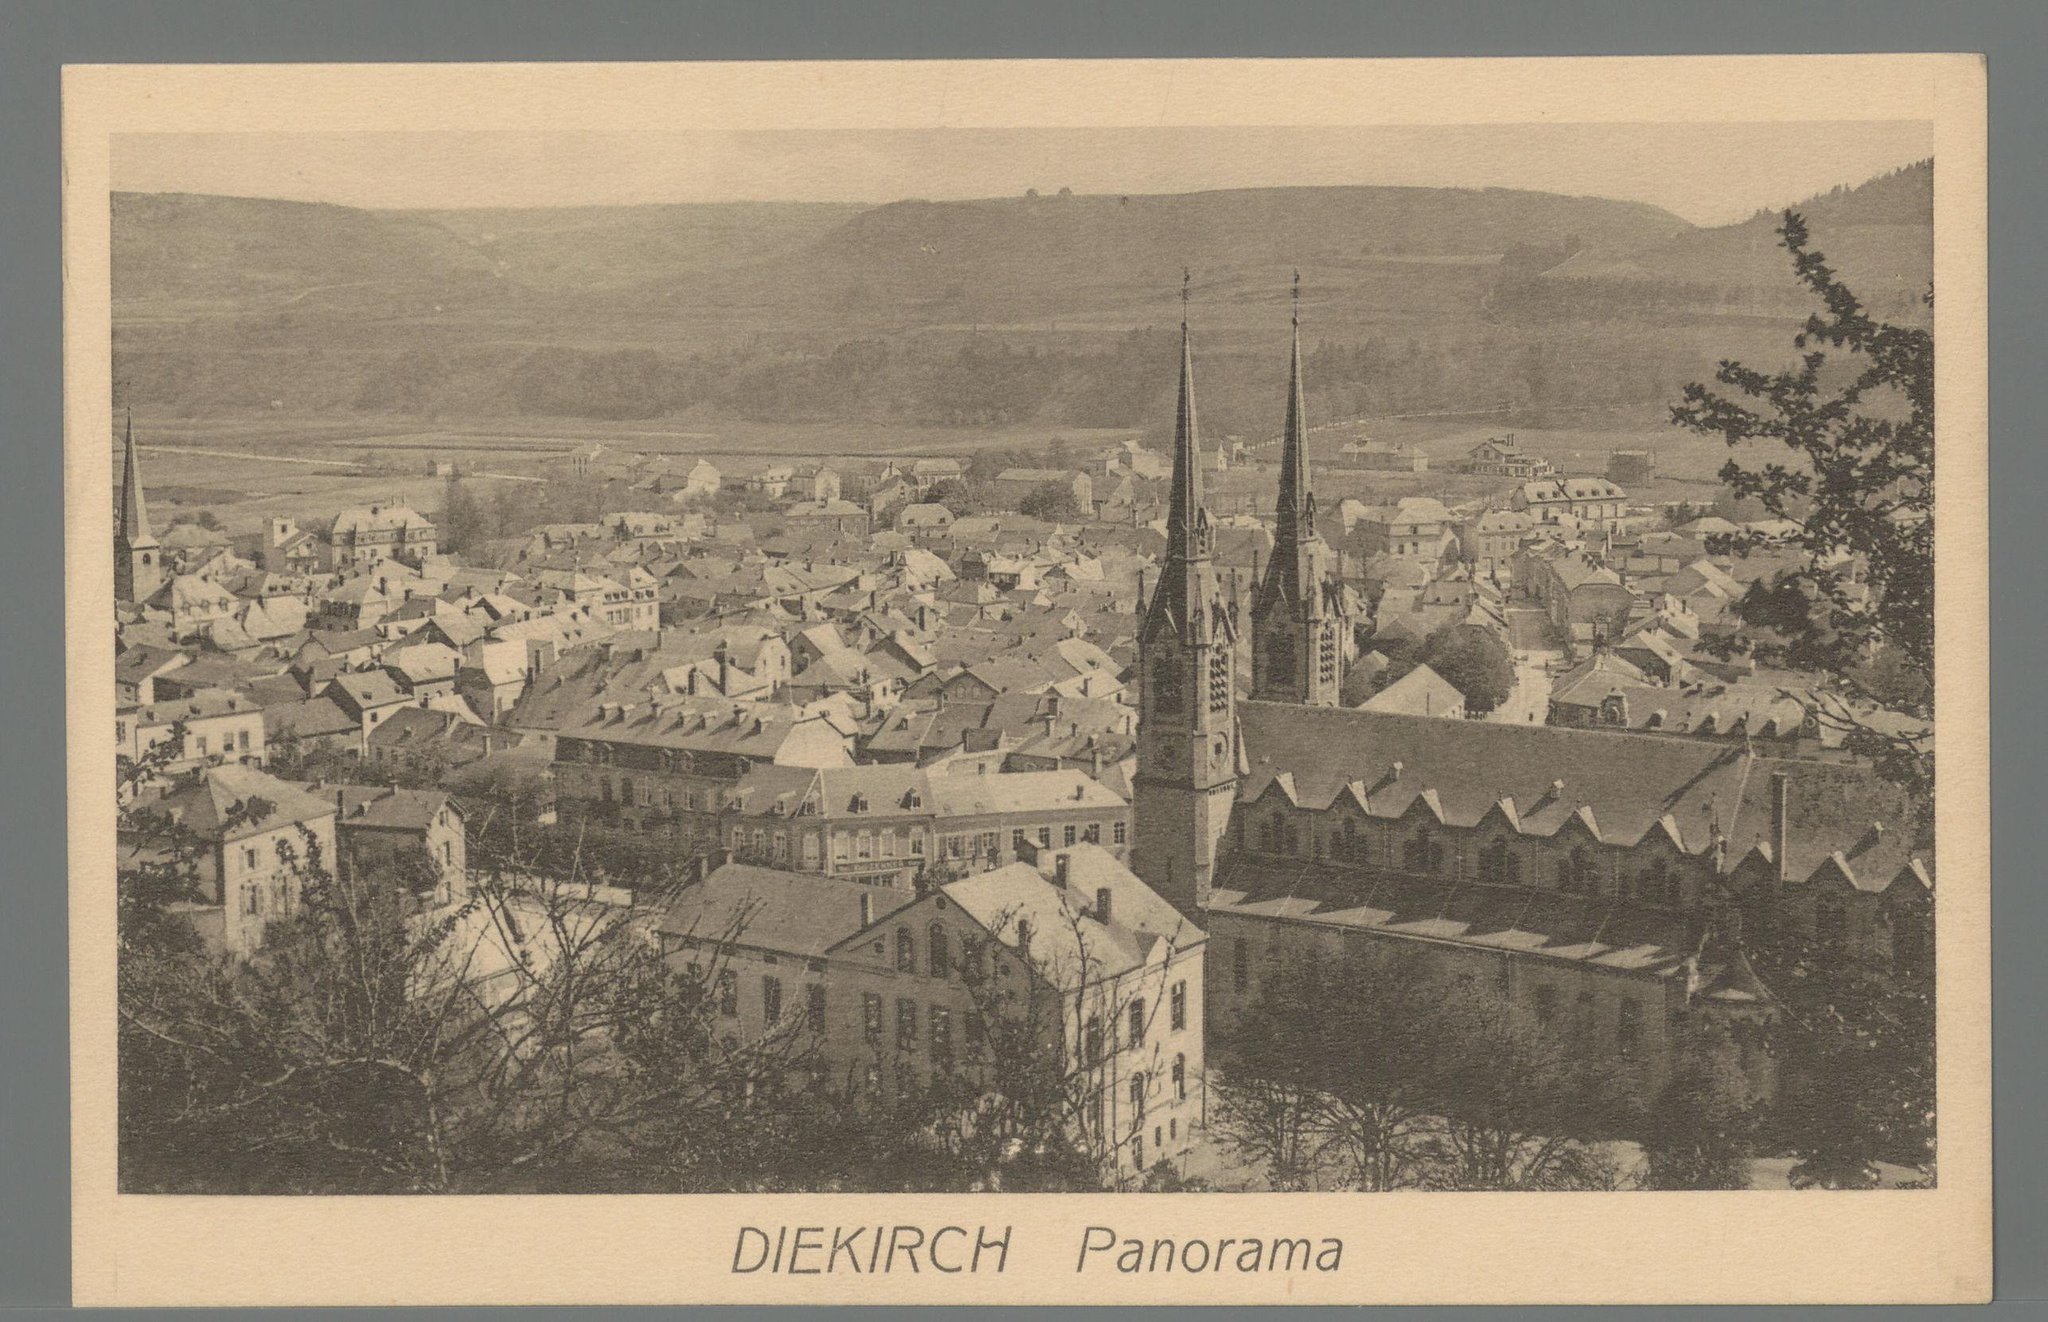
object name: photomechanical print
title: Diekirch. Panorama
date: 1906-1930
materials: cardboard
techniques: photograph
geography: diekirch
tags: church (exterior), prospect of city, town panorama, silhouette of city